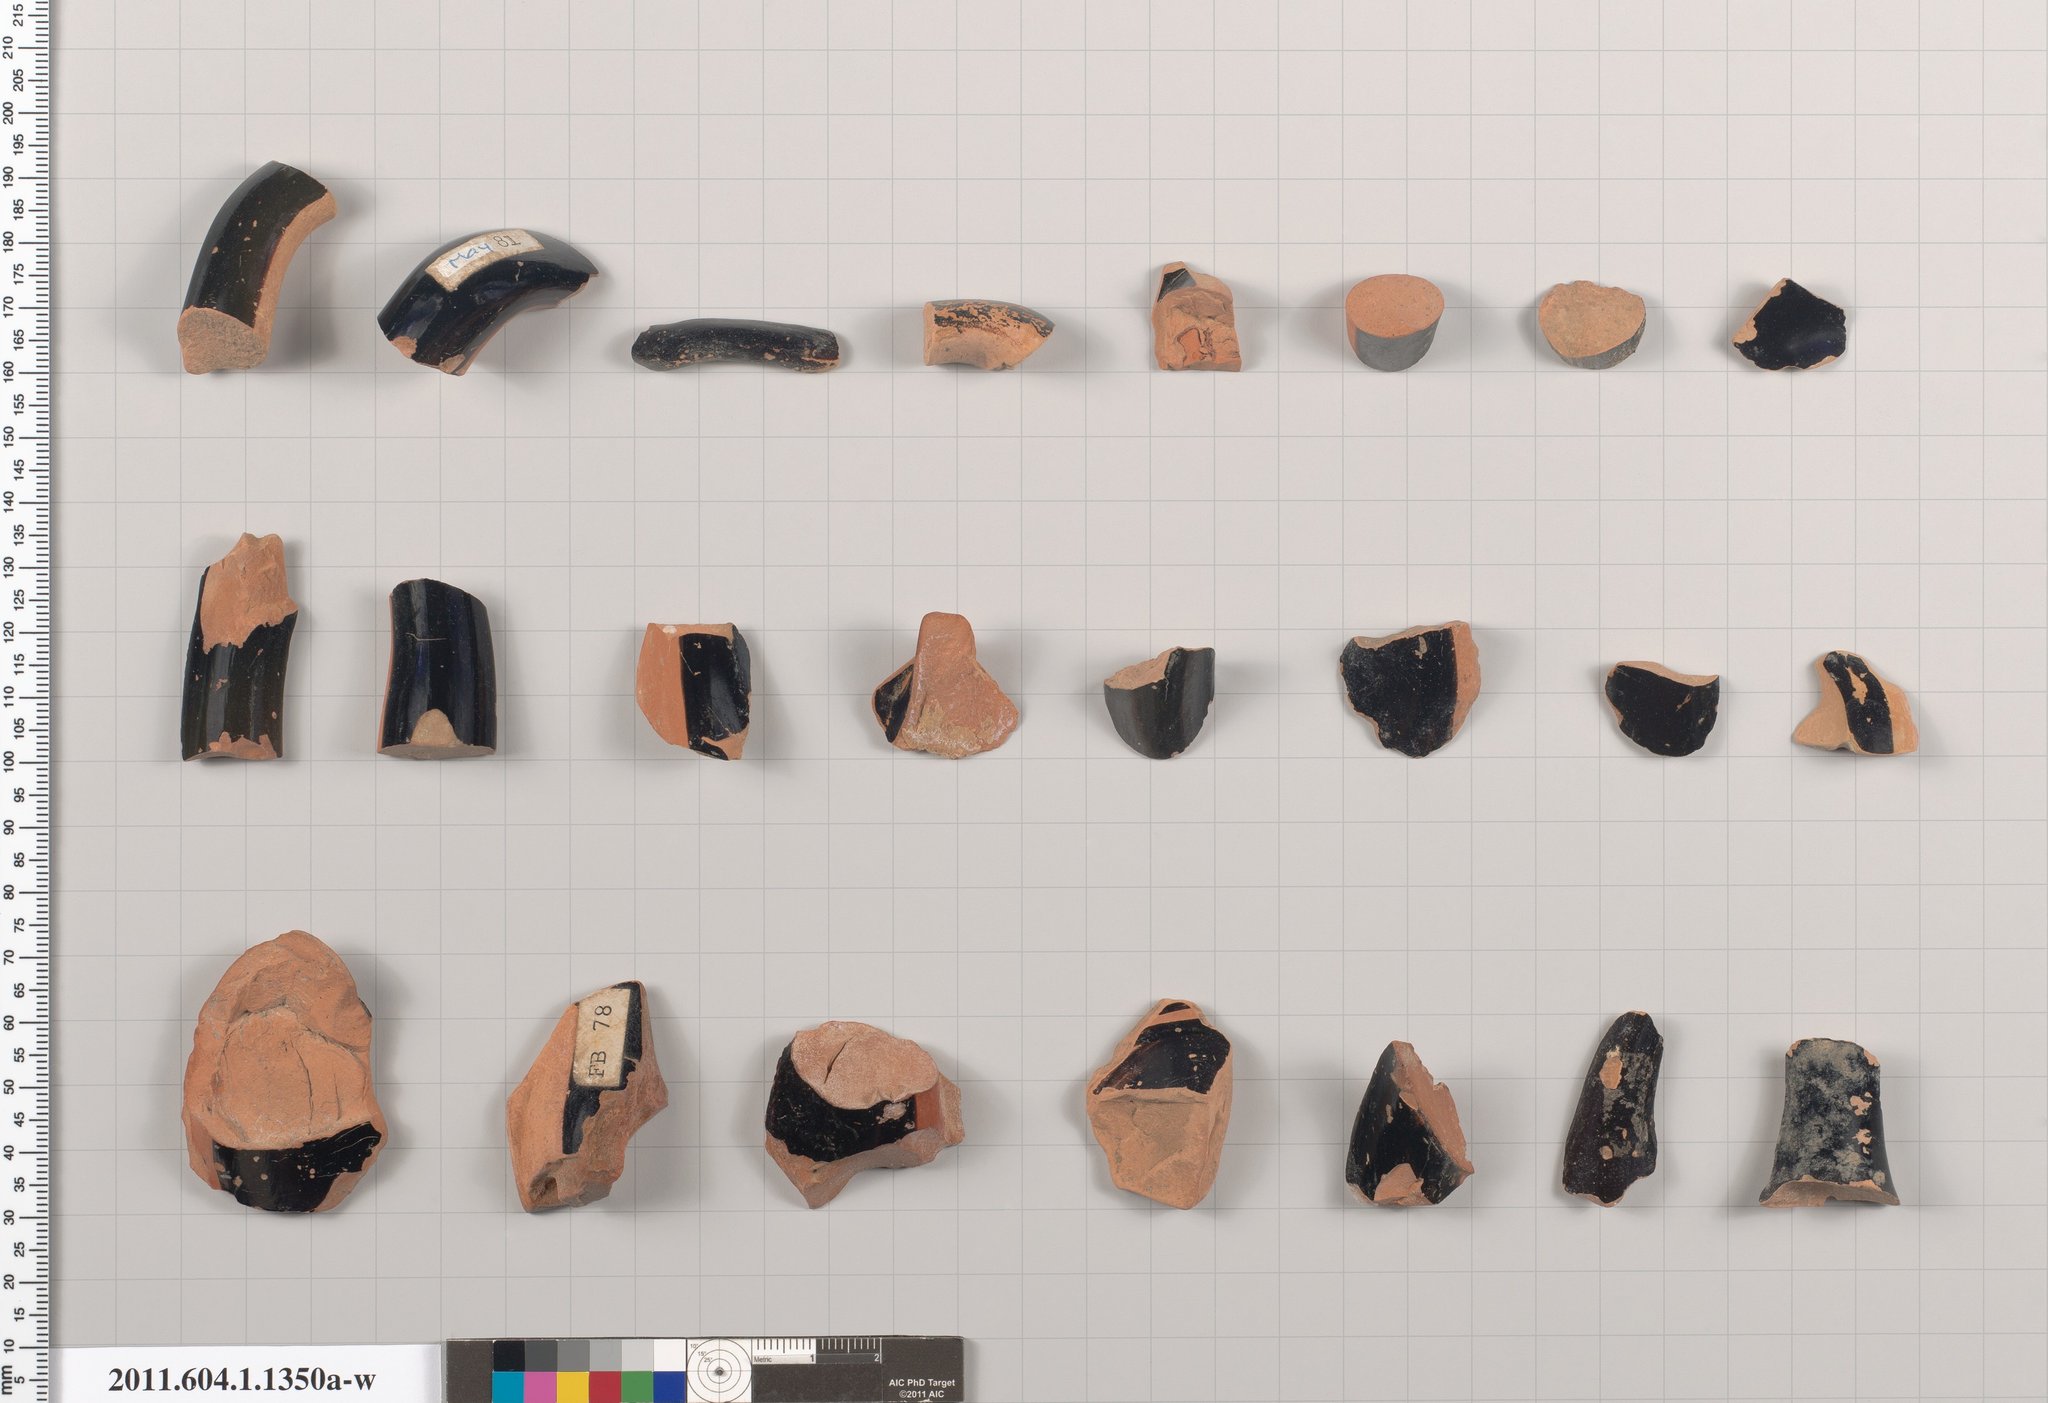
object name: kylix fragment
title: Terracotta fragments of kylikes (drinking cups)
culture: greek, attic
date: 500-401 BCE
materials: terracotta